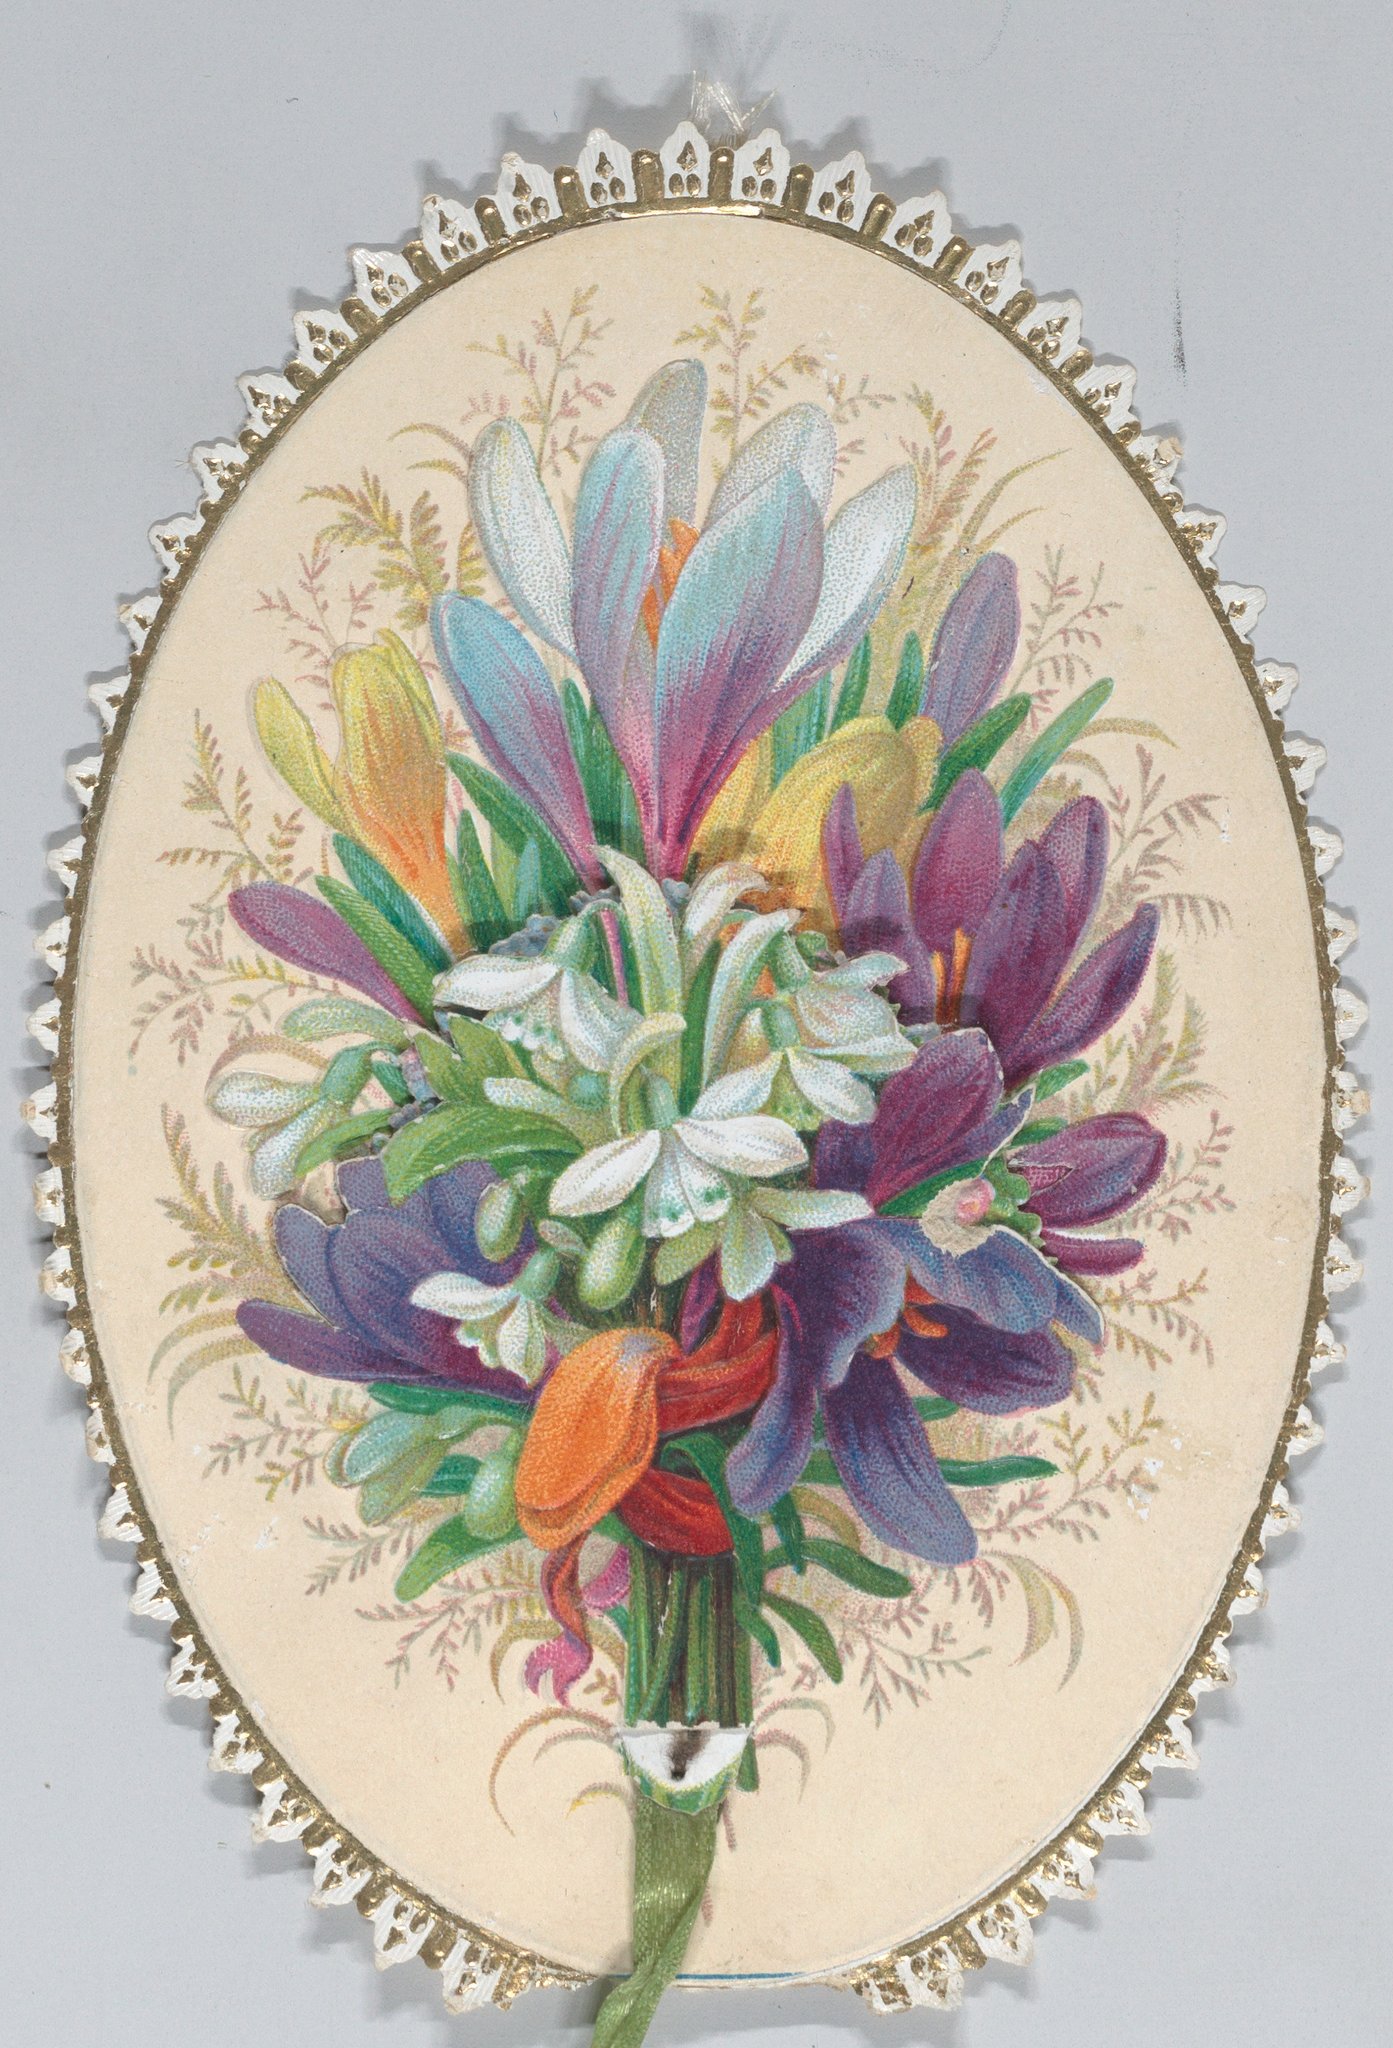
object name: valentine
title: Valentine - Mechanical bouquet,crocus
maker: anonymous, british, 19th century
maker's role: artist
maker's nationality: british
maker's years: 1800-1900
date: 1875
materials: ribbon, silk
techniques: chromolithography, cutting, gilding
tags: flowers